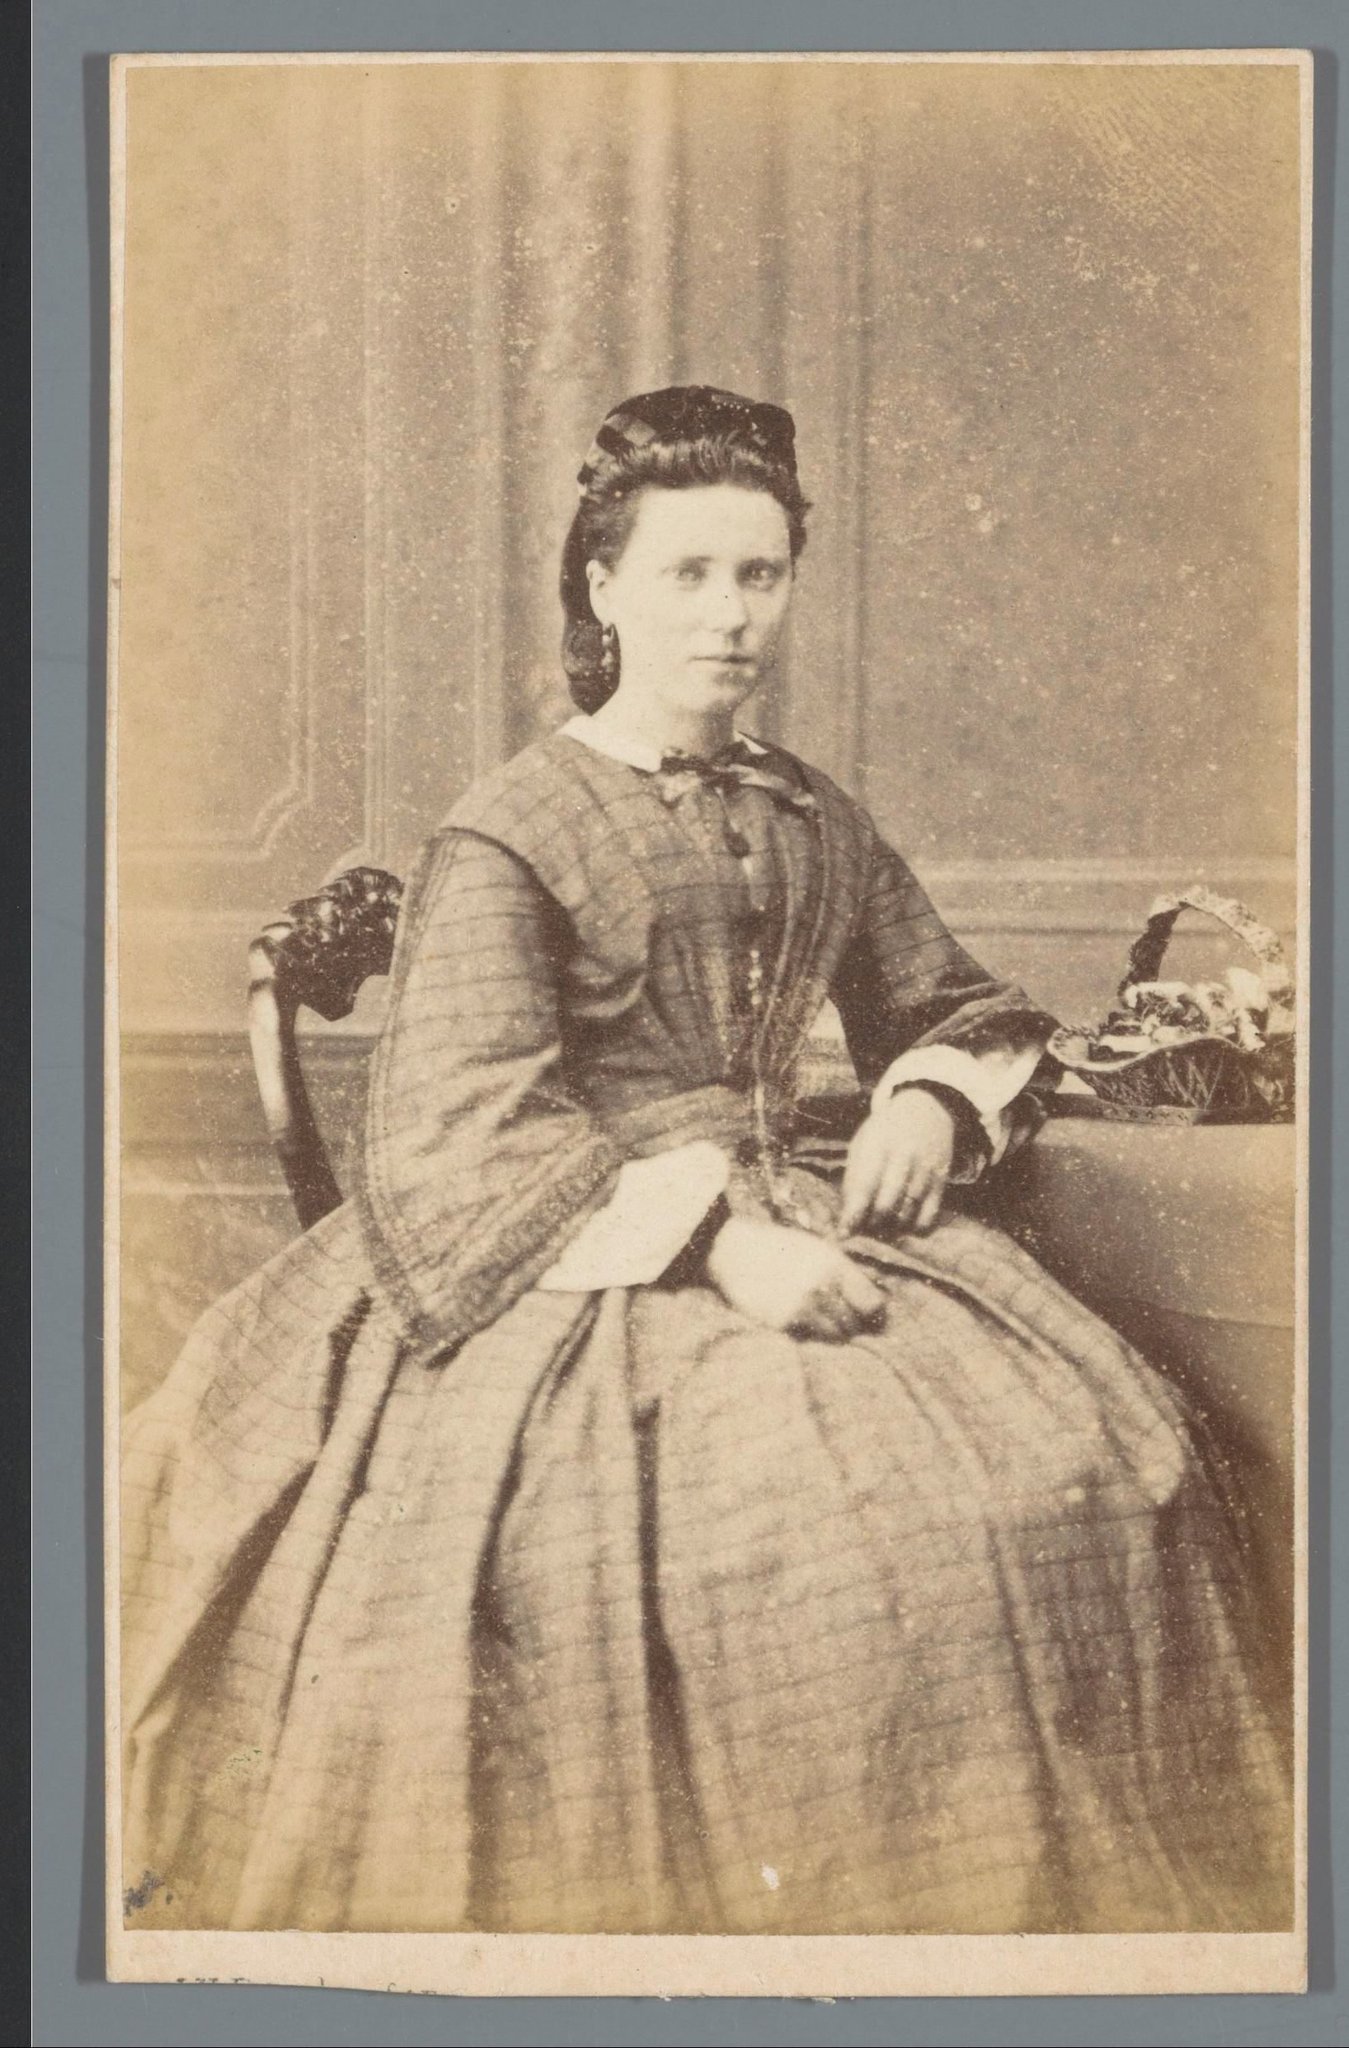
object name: photograph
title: Portret van een onbekende vrouw, zittend aan tafel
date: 1864-1880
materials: cardboard, paper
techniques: albumen print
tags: sitting figure, historical persons - bb - woman